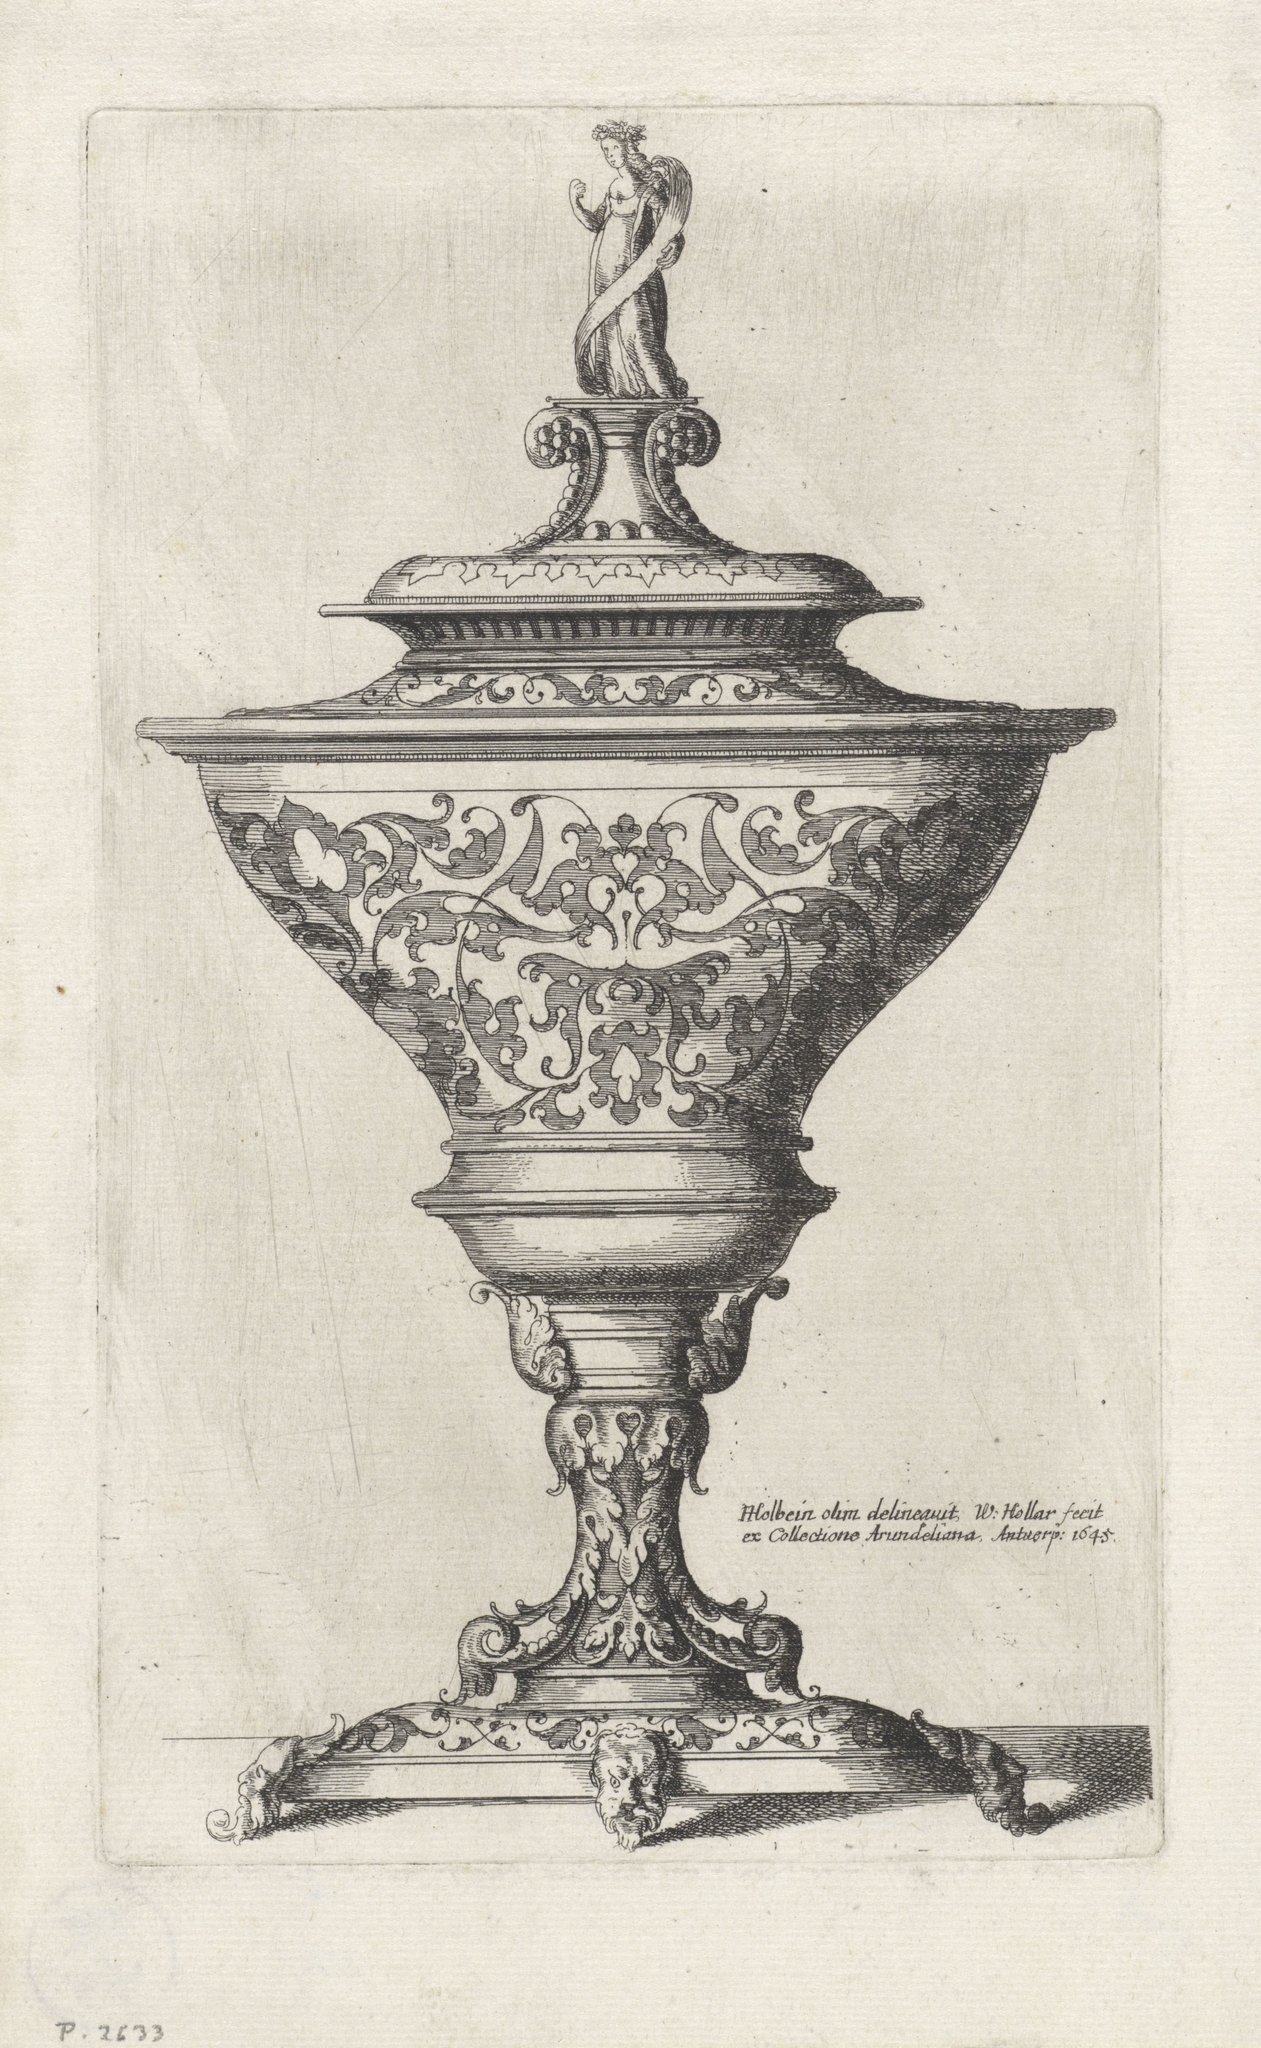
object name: print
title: Ornamentele bokaal met staande vrouw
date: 1645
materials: paper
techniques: etching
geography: antwerp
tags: laid table: table-ware, table-decoration, etc.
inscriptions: collector's mark: Lugt 151, collector's mark: Lugt 2760, collector's mark: Lugt 2228, collector's mark: Lugt 514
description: Ontwerp voor een ornamentele bokaal met staande vrouw. De schaal staat op pootjes in de vorm van mascarons.